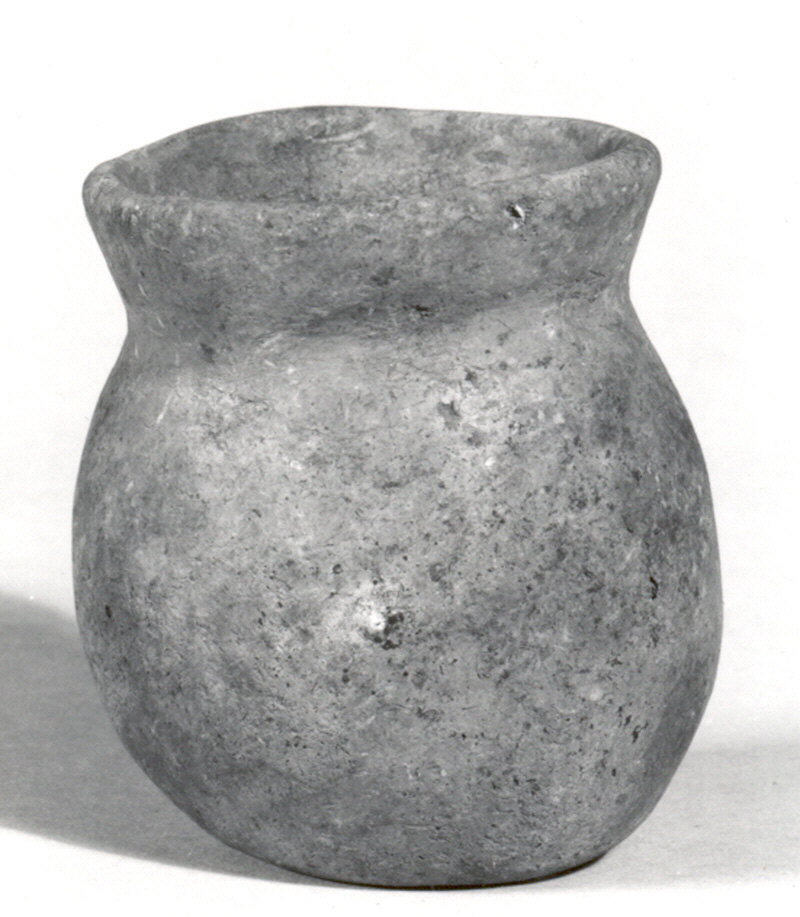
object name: pot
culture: iranian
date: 6000-5001 BCE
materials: ceramic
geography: iran